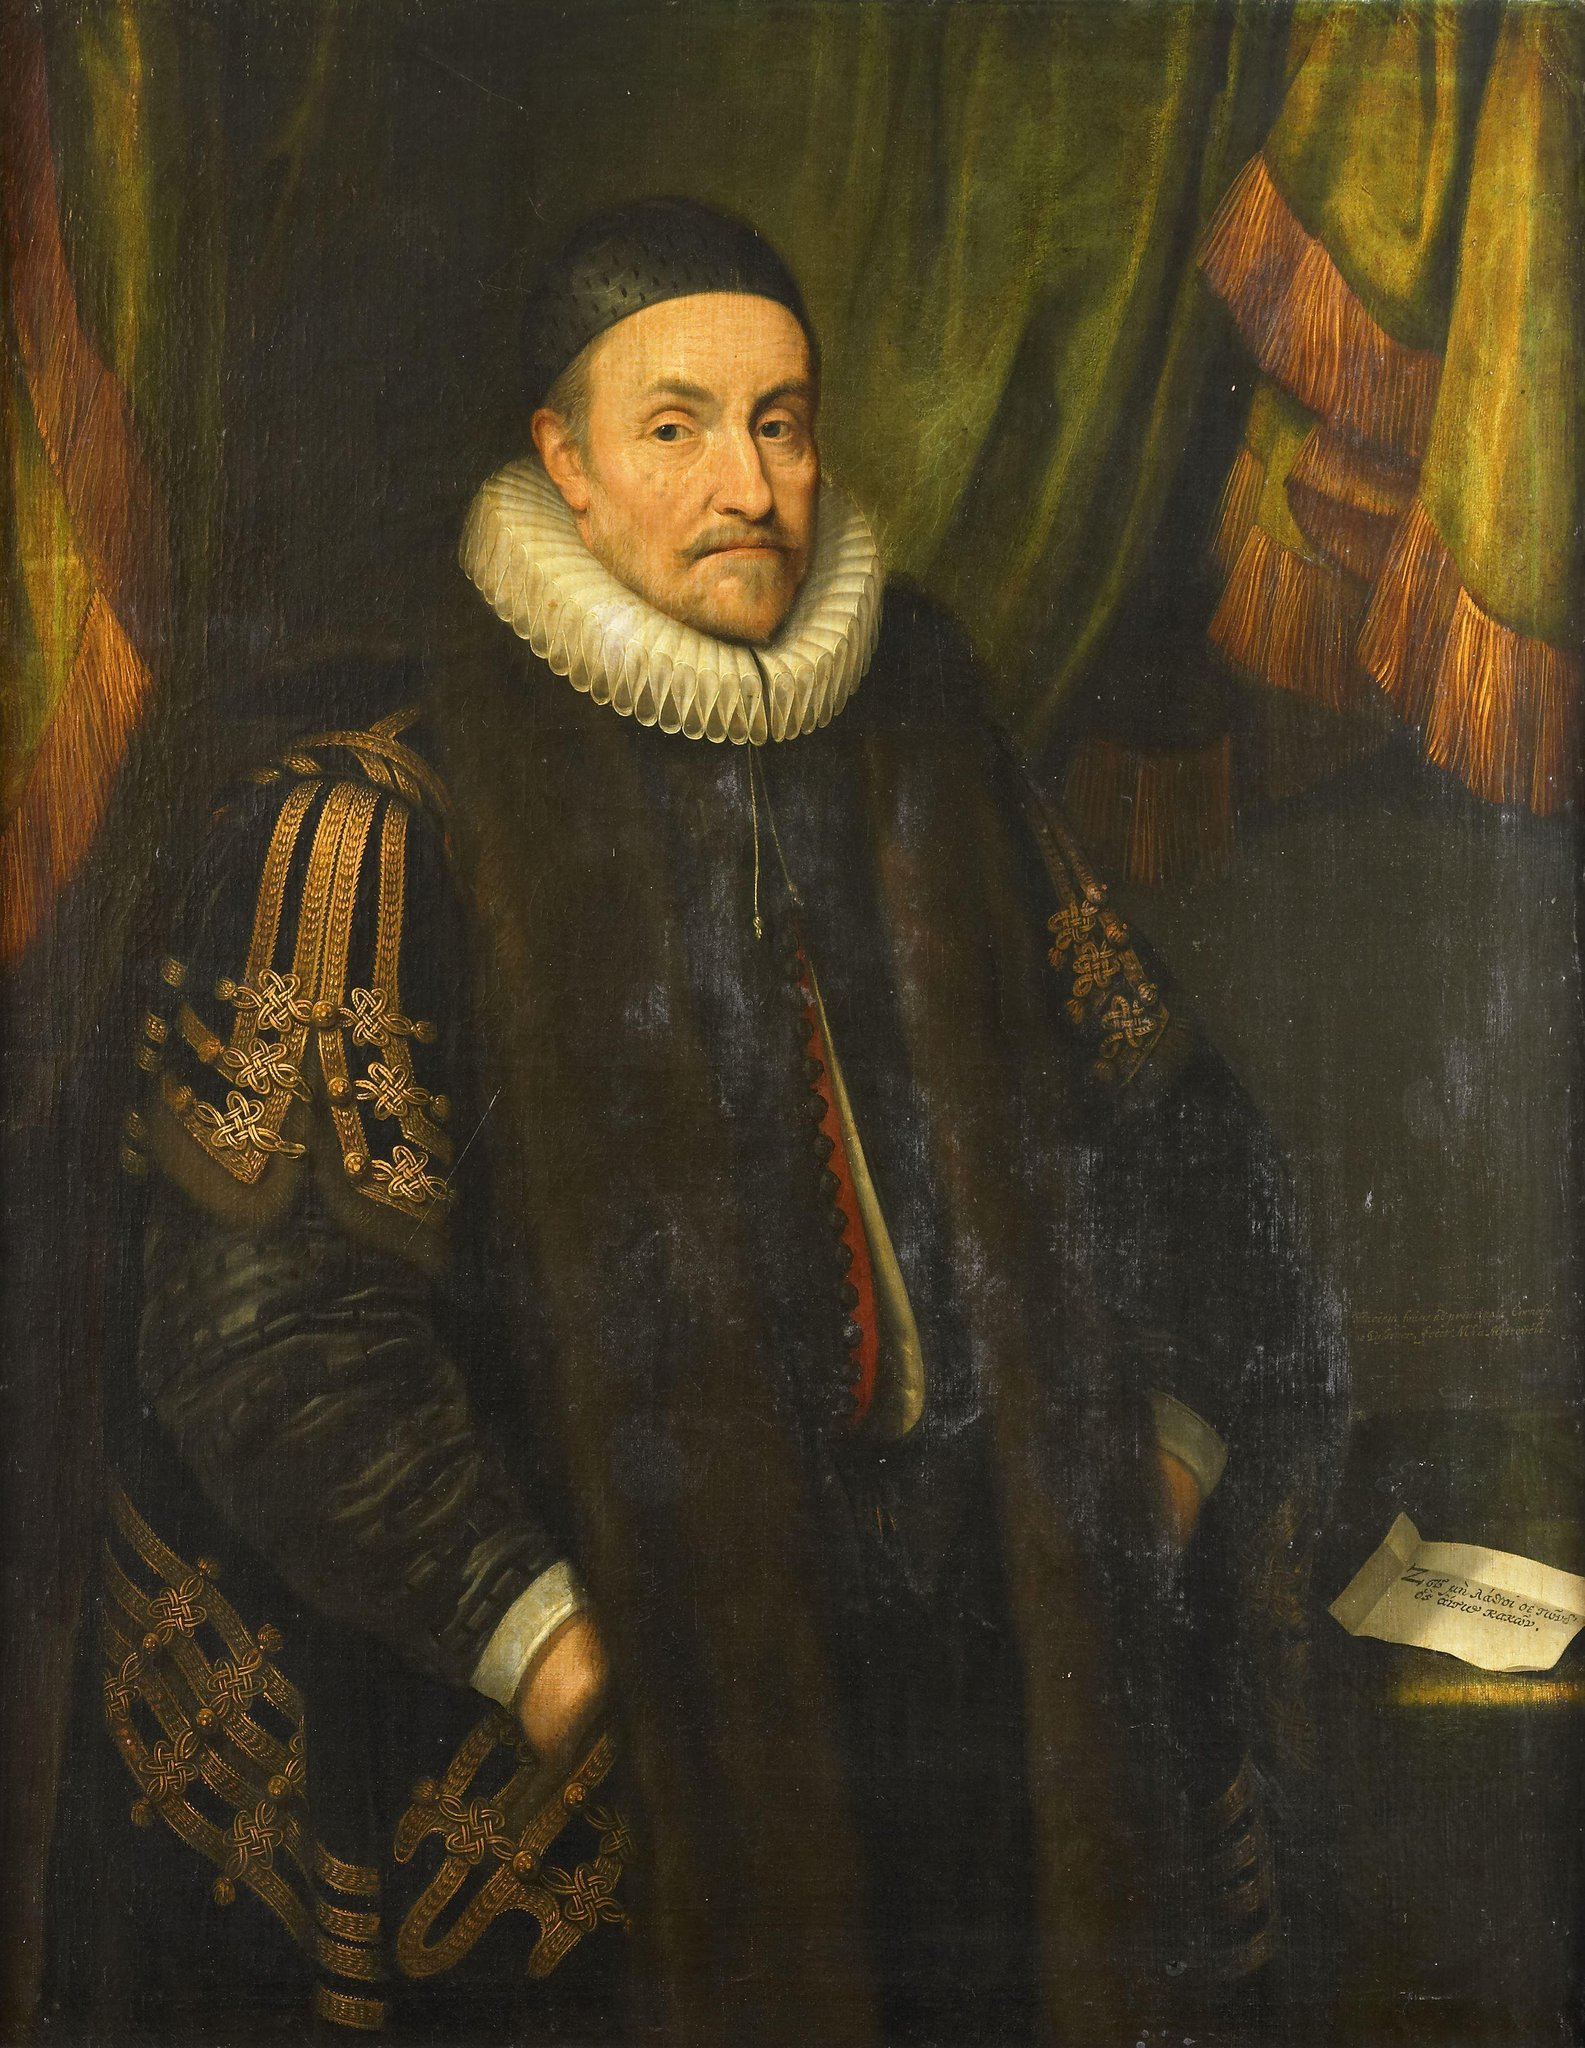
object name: painting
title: Portrait of Willem I (1533-84), Prince of Orange, called William the Silent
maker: michiel jansz van mierevelt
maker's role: draughtsman, painter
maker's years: 1567-1641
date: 1632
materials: canvas, oil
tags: delft, william i (prince of orange), historical persons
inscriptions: inscription, centre right, on the piece of paper: ‘Ζεύ μὴ λάθοι σε τώνδ᾽ ὂς αἲτιος ϰαϰών’, signature, centre right: ‘Faciem huius ad principale Cornely / de Vischer fecit A. a Miereveld.’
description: Portret van Willem I, prins van Oranje, genaamd Willem de Zwijger. Kniestuk, staand, de handen in de mantel gestoken.